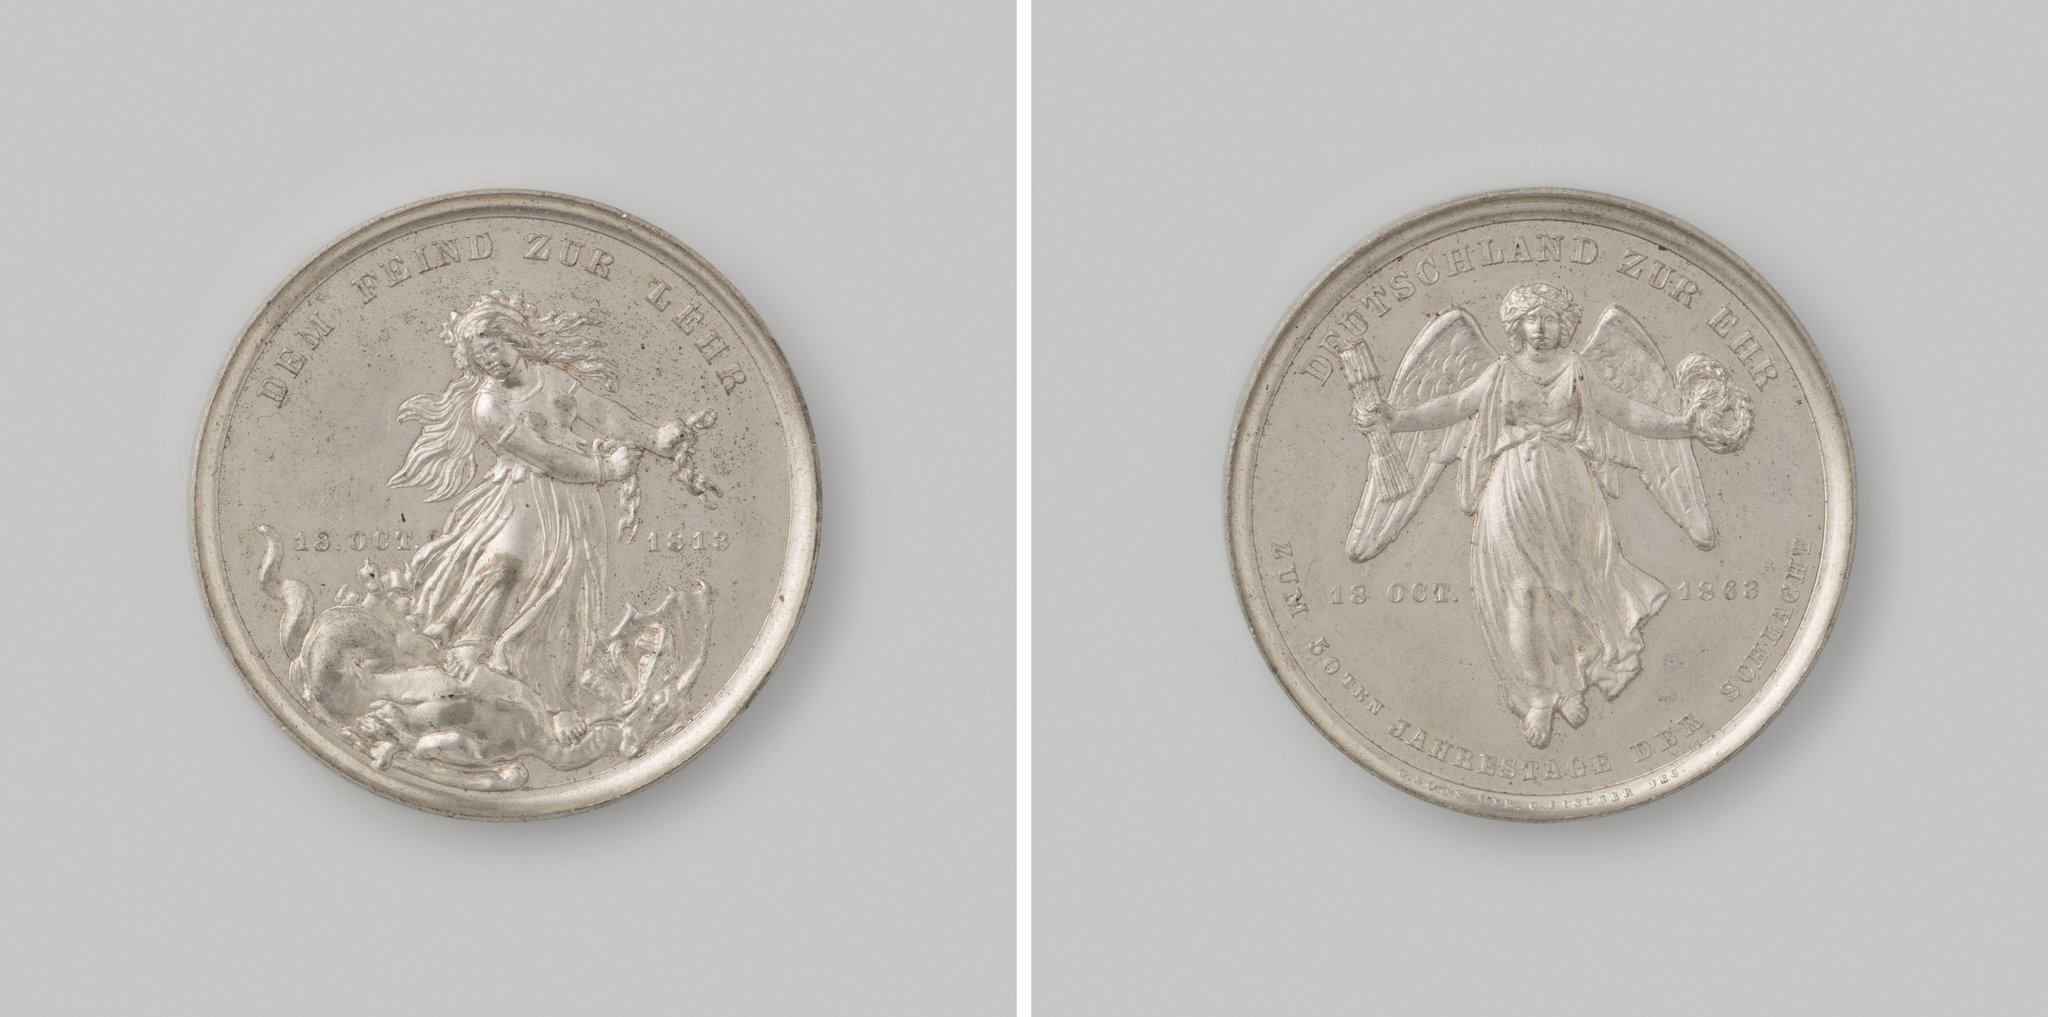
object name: history medal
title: Vijftigjarige herdenking van de Slag bij Leipzig 1863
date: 1863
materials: tin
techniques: striking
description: Tinnen penning, op de voorzijde een vrouw met verbroken ketens bij een verslagen draak, datum in het veld, met omschrift, op de keerzijde een engel met pijlenbundel en dubbele lauwerkrans, datum in het veld, met omschrift.